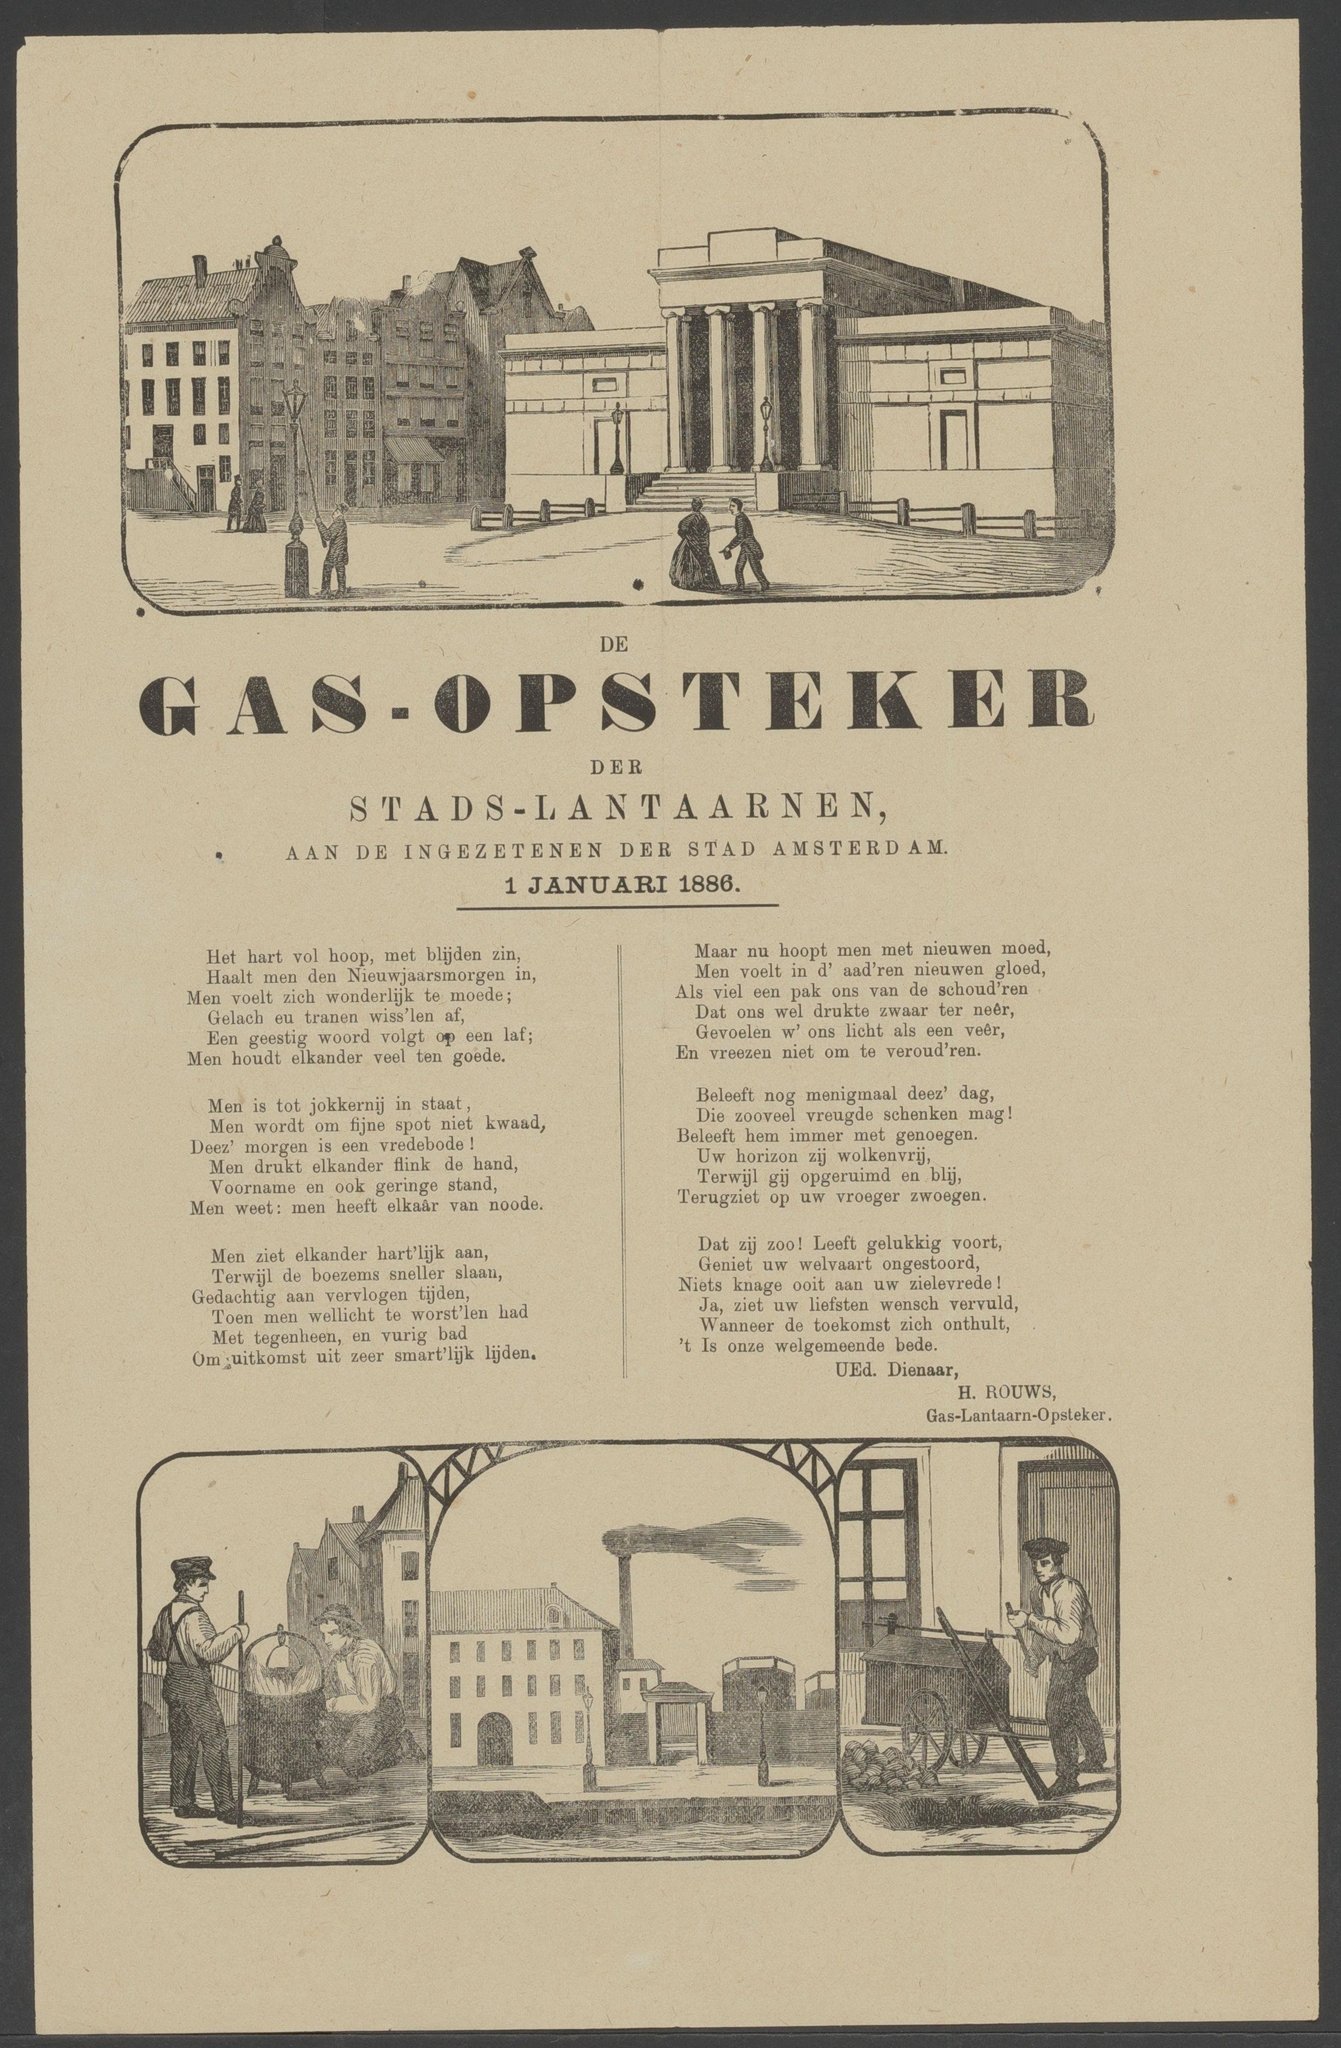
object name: print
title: De Gas-opsteker der Stads-lantaarnen, aan de ingezetenen der stad Amsterdam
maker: Anonymous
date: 1885-1886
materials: paper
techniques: letterpress printing, engraving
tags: gas-lamp, gas supply, digging (industrial process), street lighting, amsterdam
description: Nieuwjaarswens van de Amsterdamse gaslantaarnopstekers voor het jaar 1886. Centraal een vers in twee kolommen. Bovenaan de Dam met de beurs van Zocher te Amsterdam. Onderaan de Hollandsche Gasfabriek en twee gasfitters aan het werk. Van de gaslantaarnopsteker: H. Rouws. Onderwerpsrubrieken binnen de Atlas Zeden en Gewoonten: Zeden en gewoonten in engeren zin, Volksleven, Volksbladen, Nieuwjaars- en Kerstwenschen, Amsterdam.